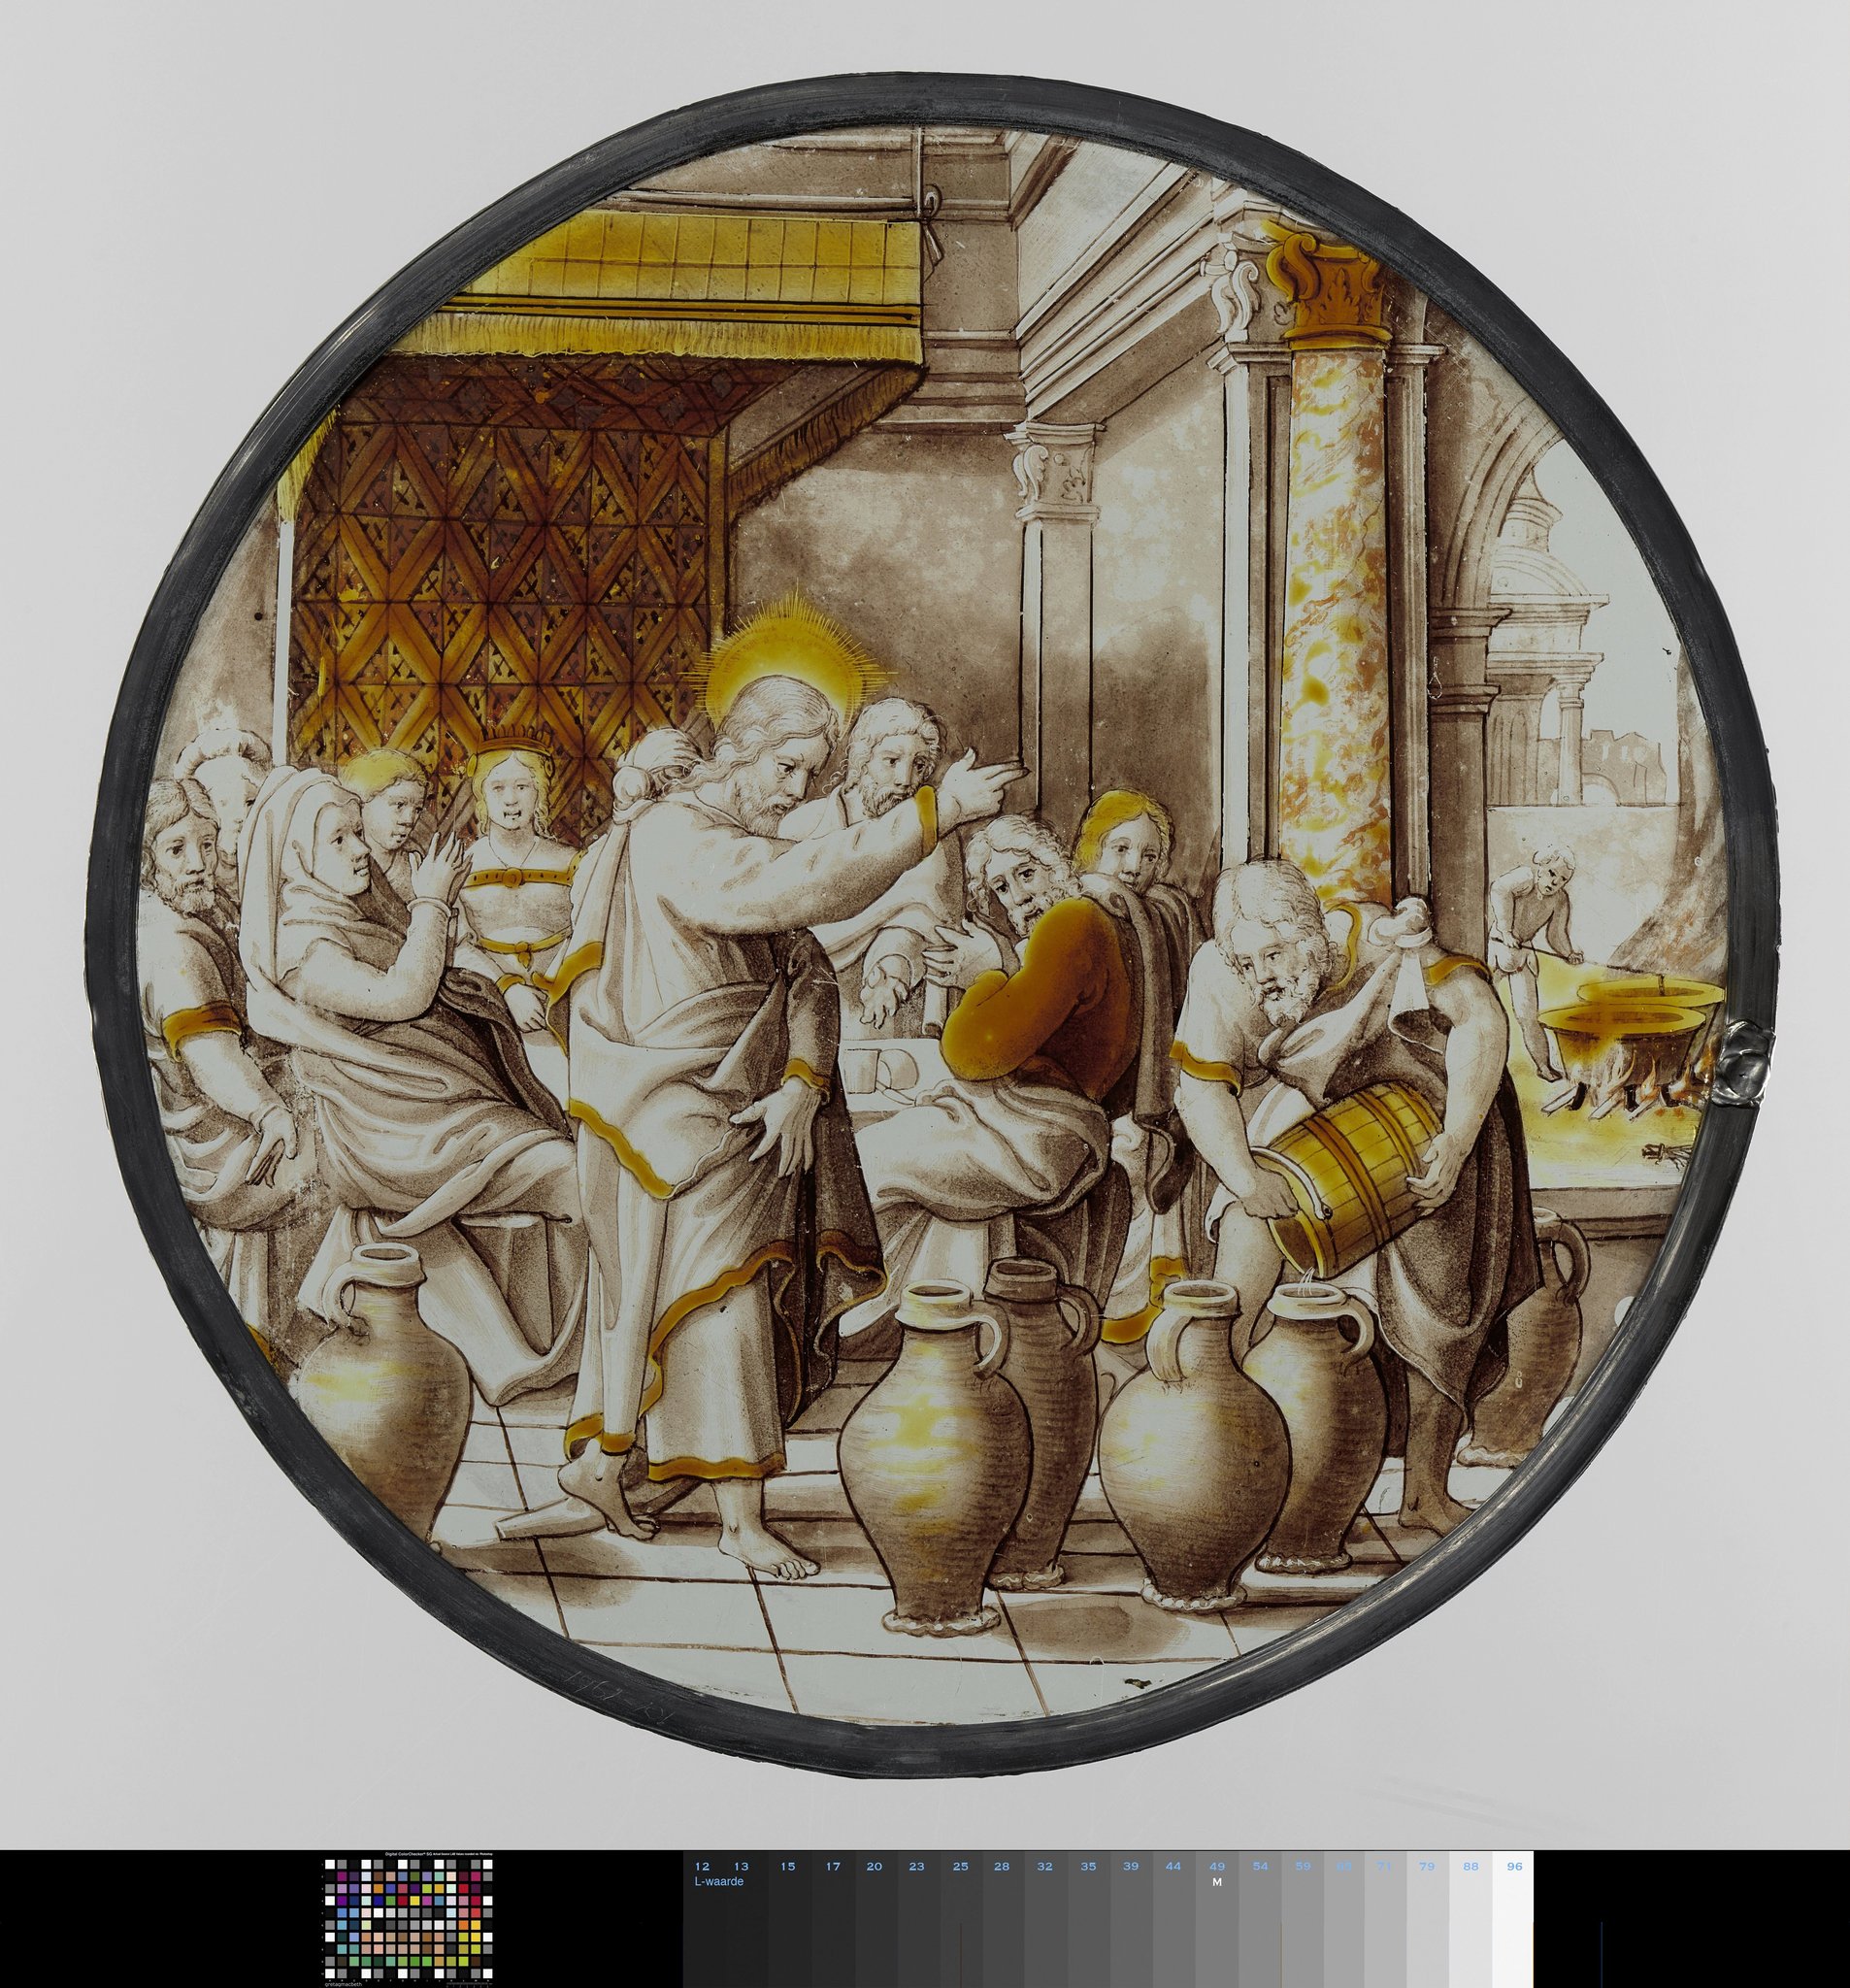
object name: light window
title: Ruit met de Bruiloft te Kana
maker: Anonymous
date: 1525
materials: glass, lead, pigment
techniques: leading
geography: southern netherlands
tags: christ orders (six) jars to be filled with water ~ marriage-feast at cana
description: The Marriage at Cana. Stained glass, Southern Netherlands, c. 1525 - 1550.